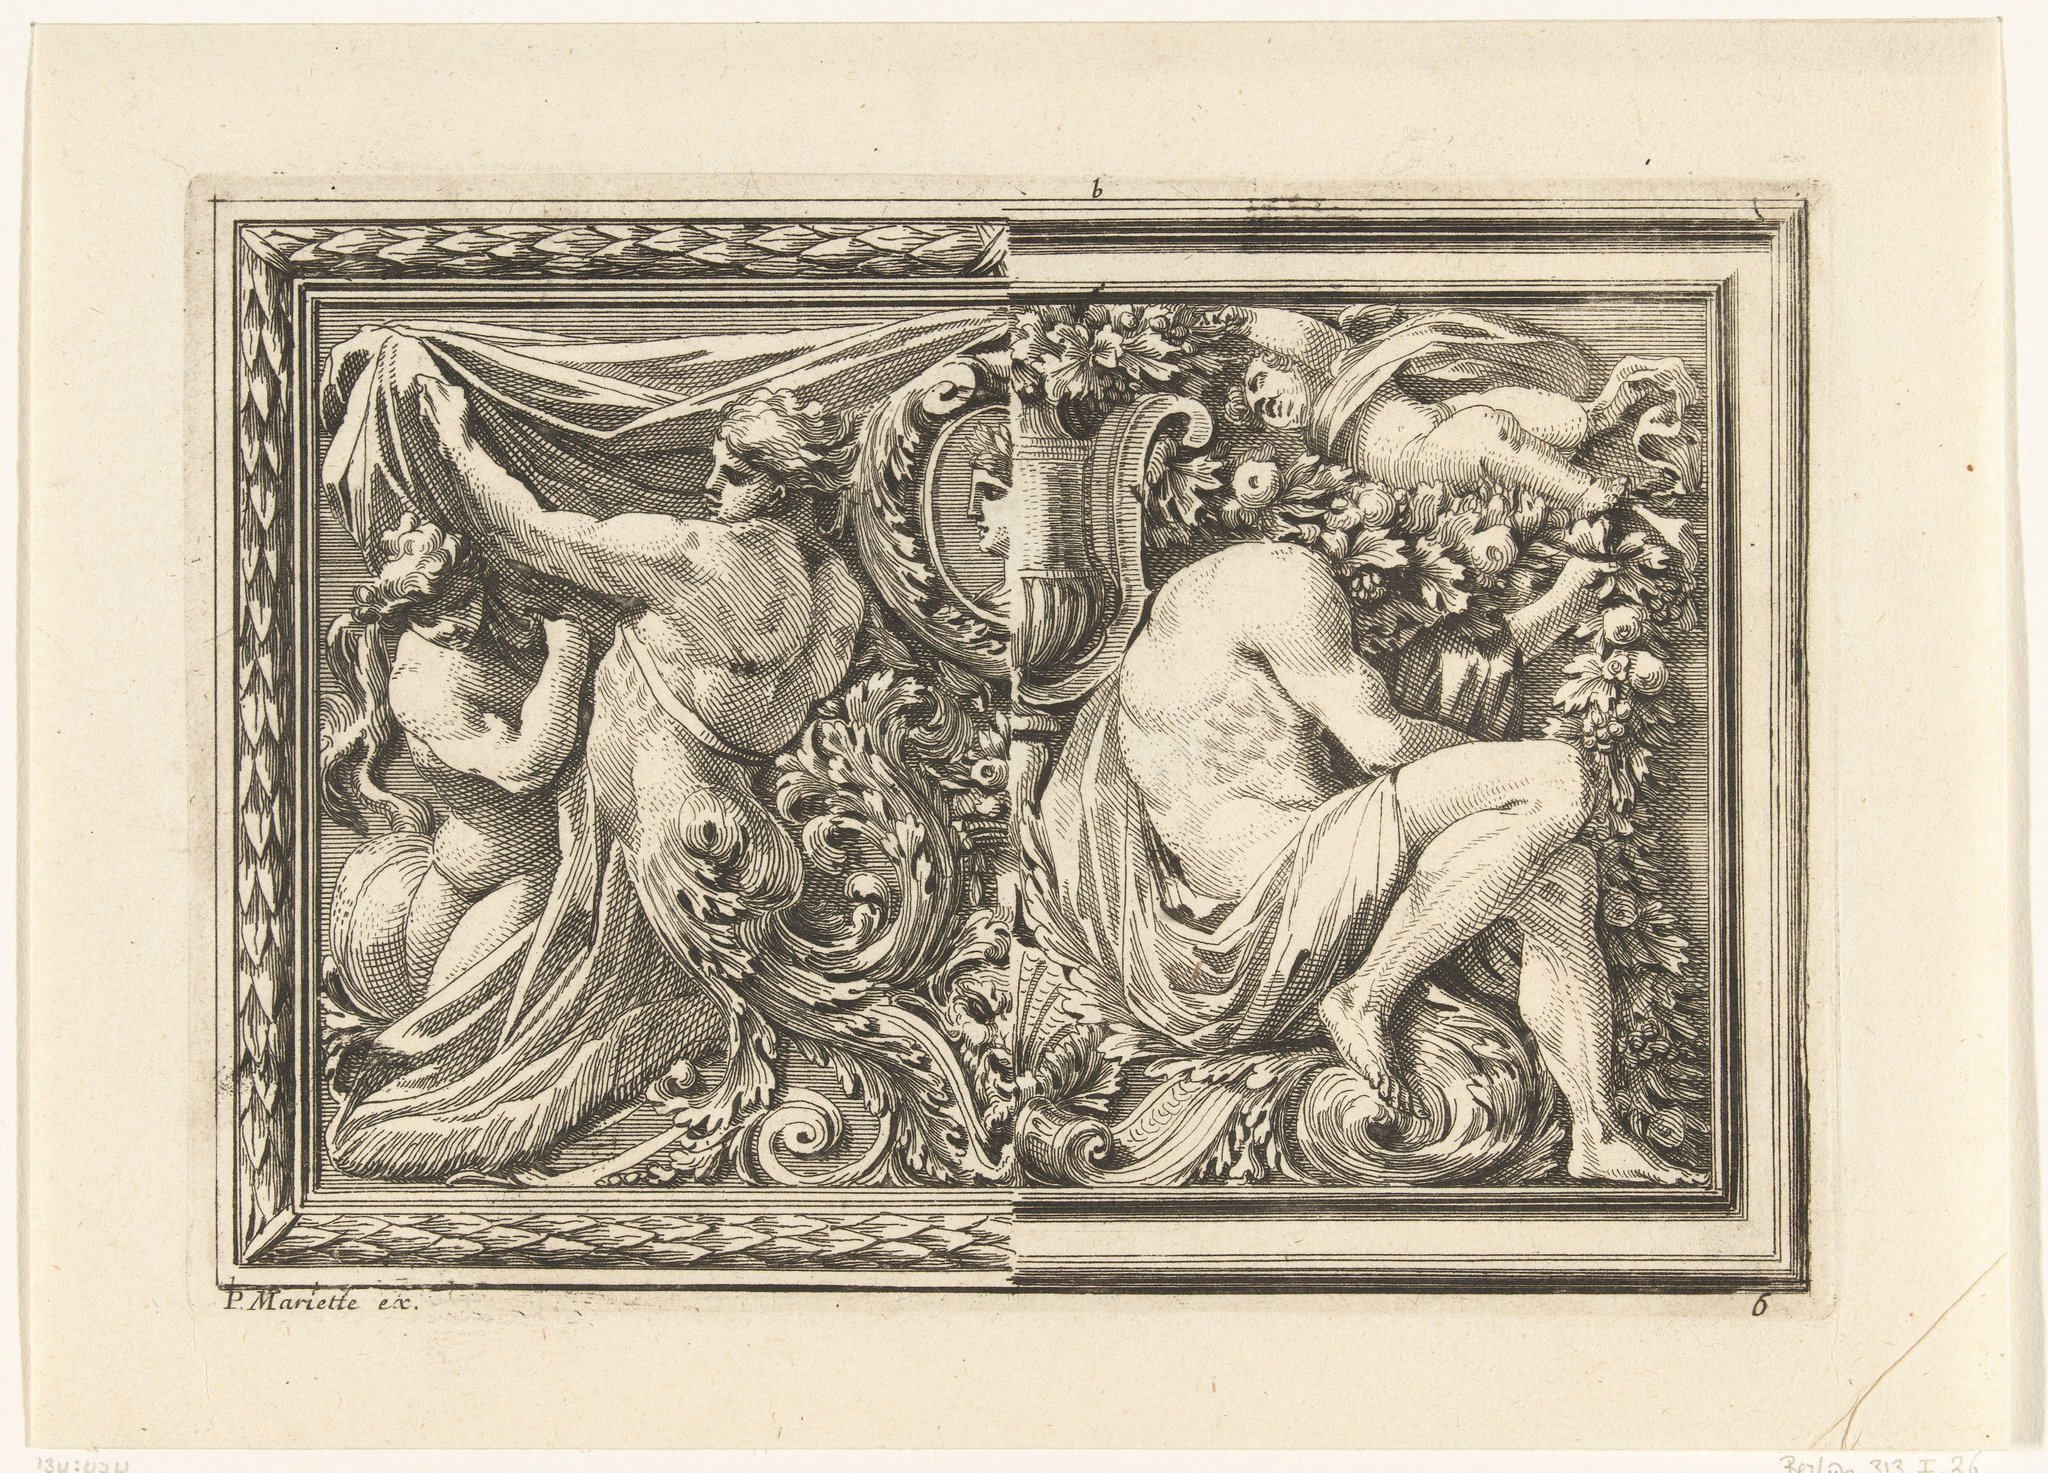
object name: ornament print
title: Ornements de paneaux a la Romaine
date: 1667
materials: paper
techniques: etching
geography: france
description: De man links ontspruit uit een bladrank en houdt een draperie boven de vrouw.